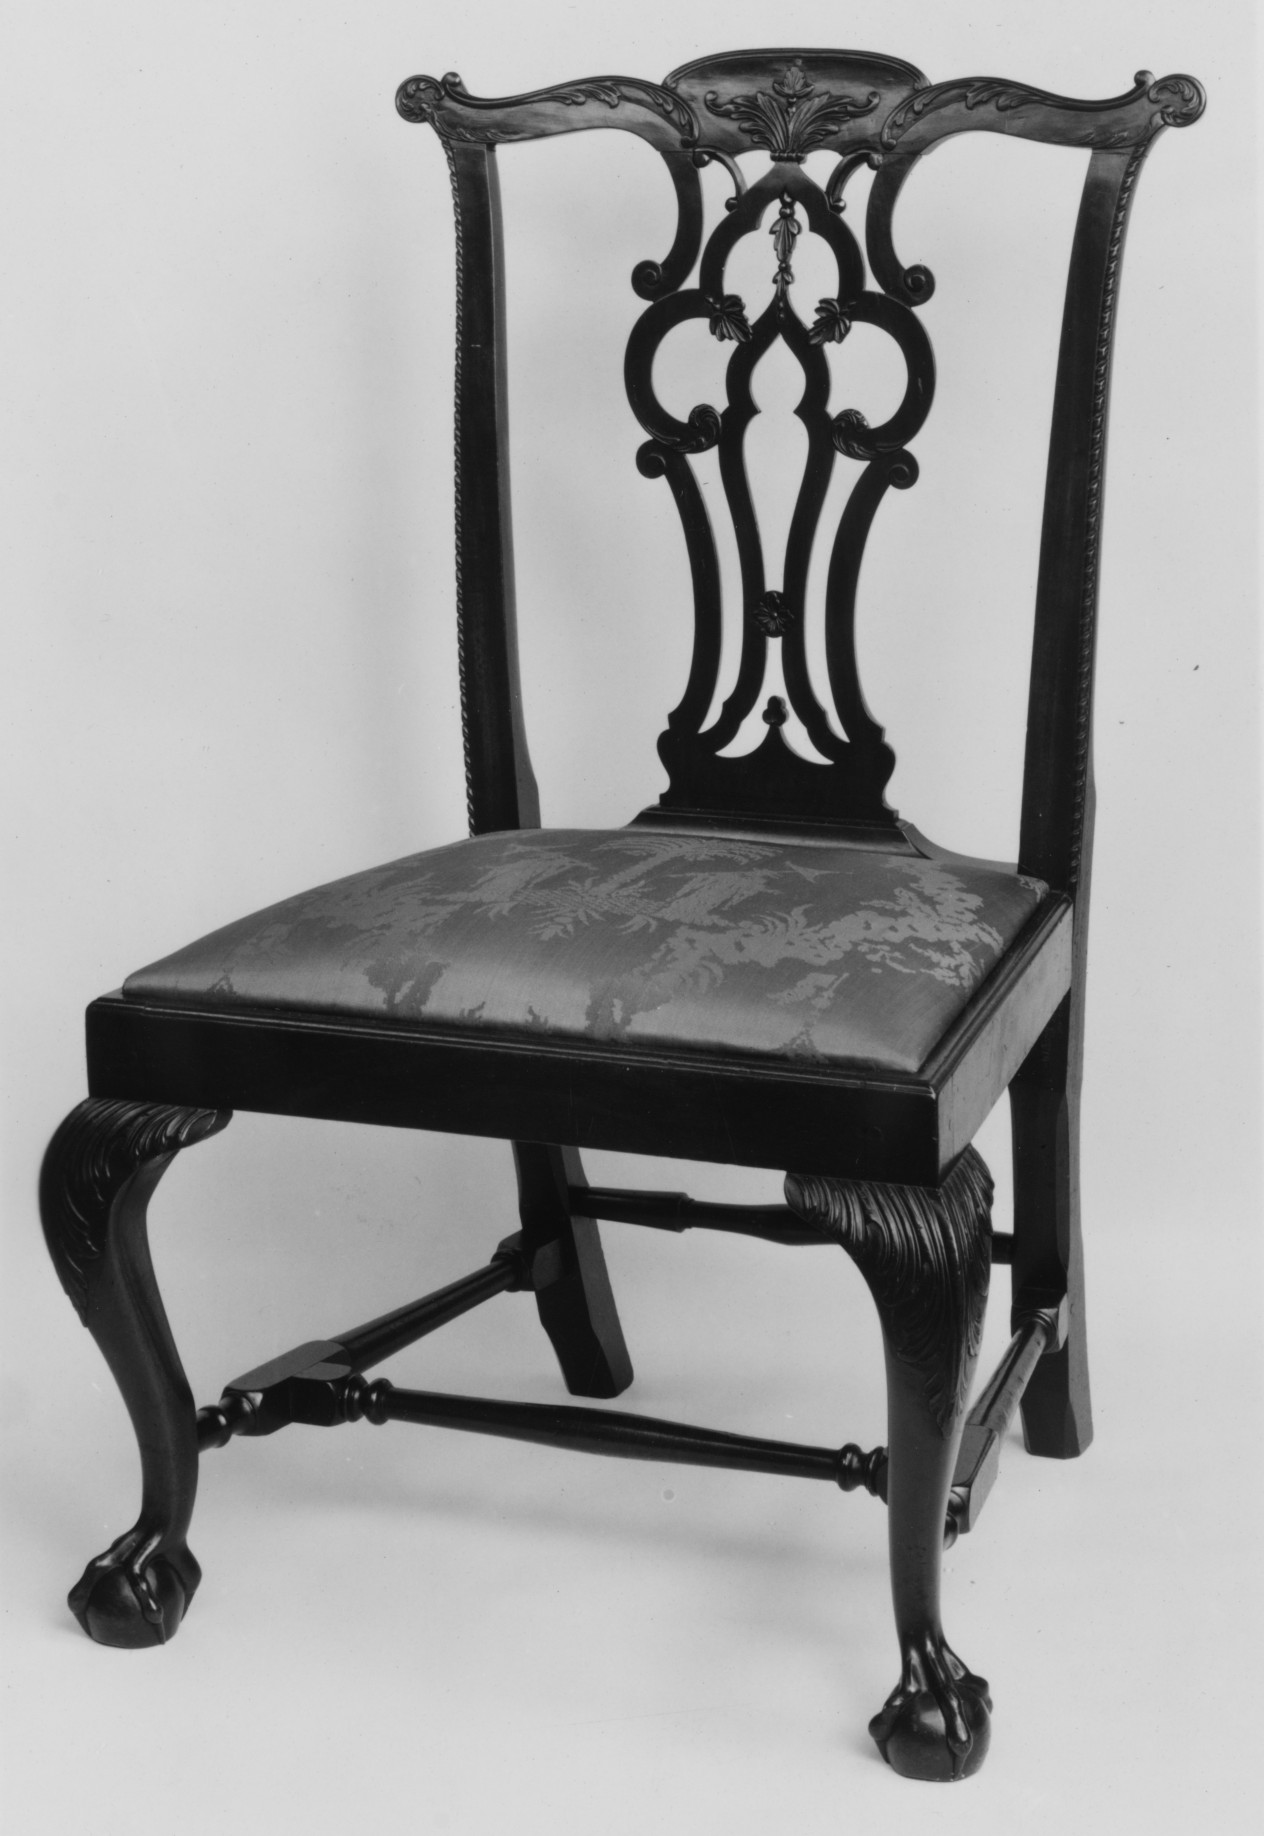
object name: side chair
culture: american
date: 1760-1790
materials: wood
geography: united states